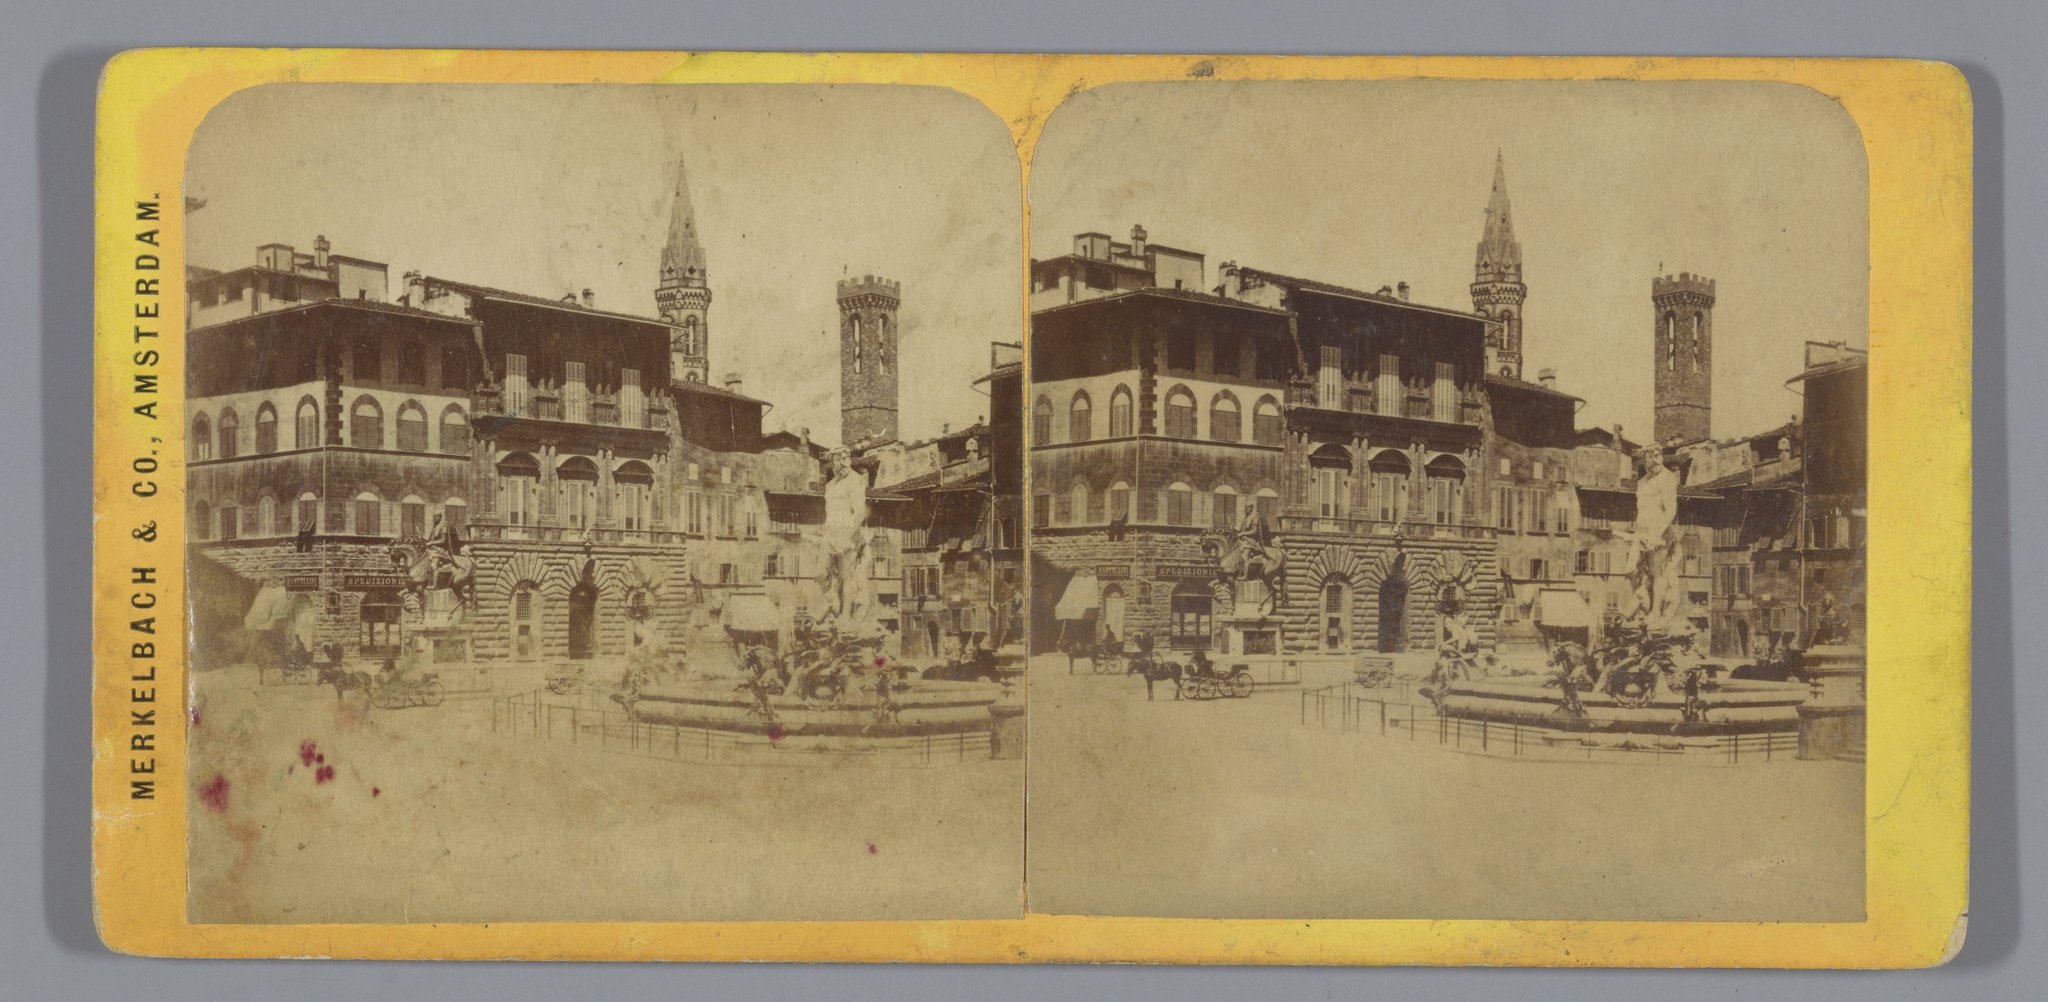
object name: stereograph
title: Piazza della Signoria te Florence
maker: Anonymous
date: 1850-1880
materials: cardboard, photographic support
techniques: albumen print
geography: piazza della signoria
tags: ornamental fountain, façade (of house or building), village square, place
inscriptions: inscription: ‘MERKELBACH & CO., AMSTERDAM.’, inscription: ‘Florence fontein van Neptunus’